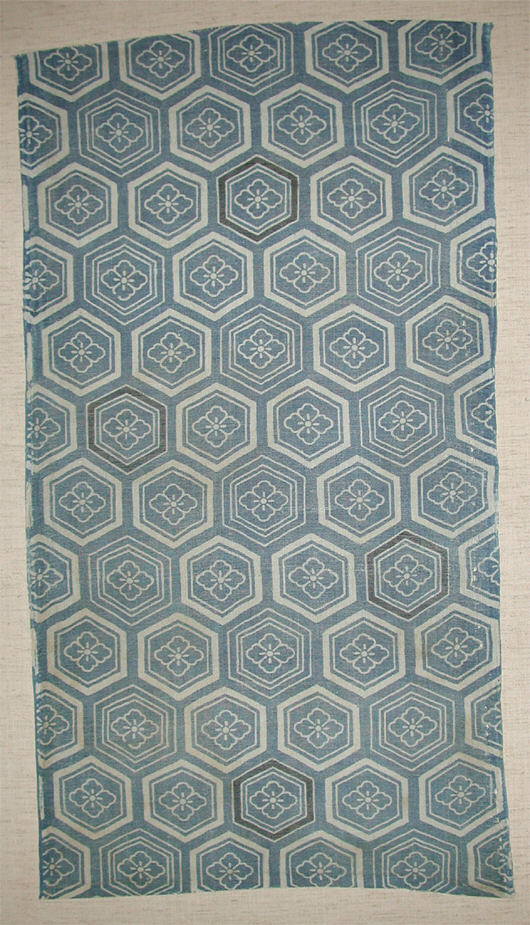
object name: piece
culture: japanese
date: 1767-1900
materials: fiber